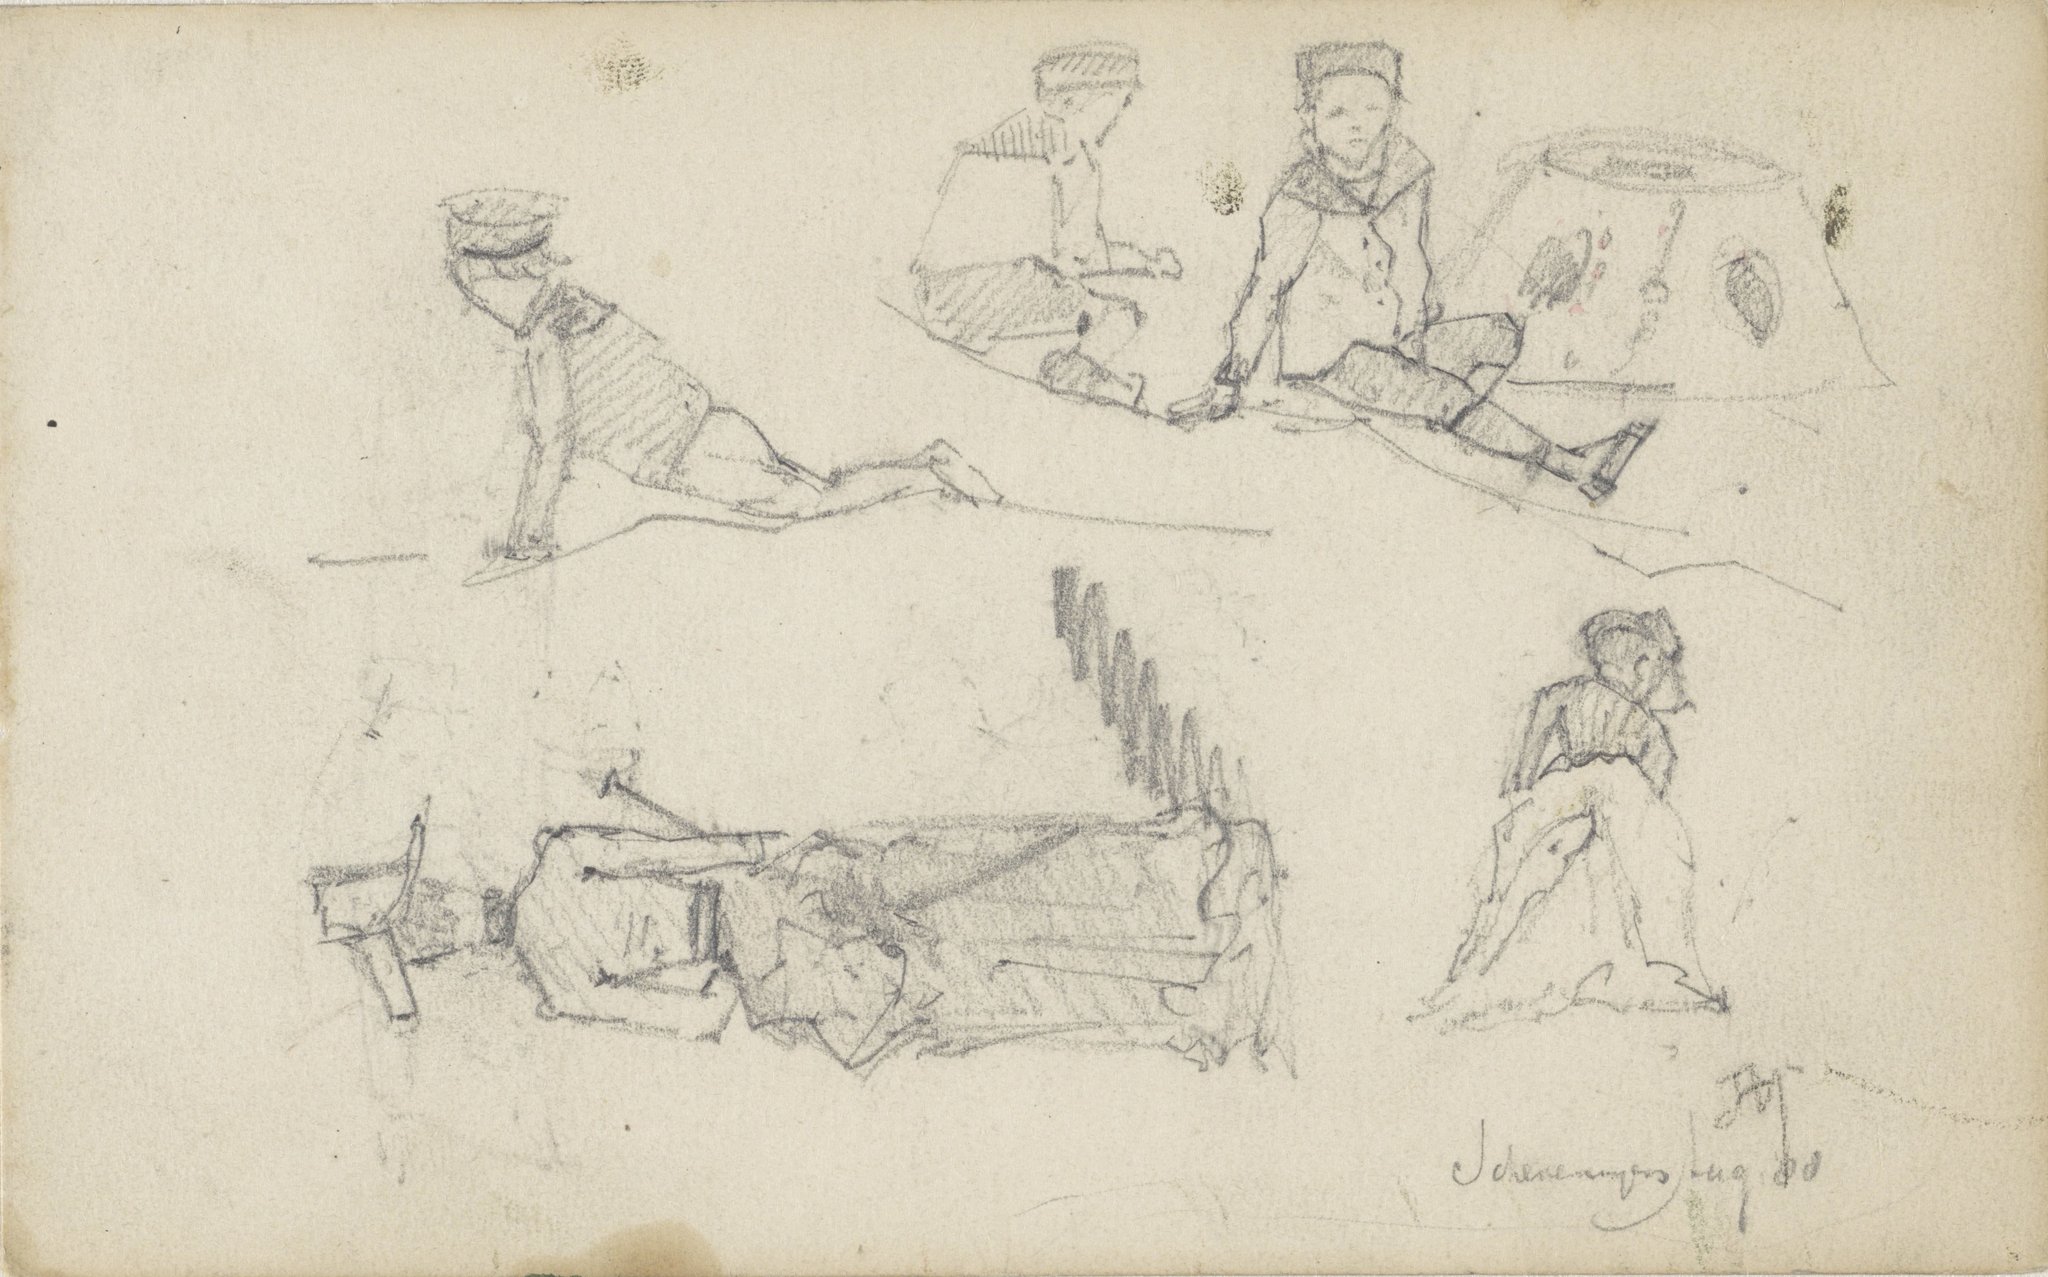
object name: drawing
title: Studies van figuren op het strand van Scheveningen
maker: johannes abraham mondt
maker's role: draughtsman, print maker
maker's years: 1859-1941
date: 1808-1888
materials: paper, pencil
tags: in or beside the water (on the beach)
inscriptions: date: ‘Aug. 88’